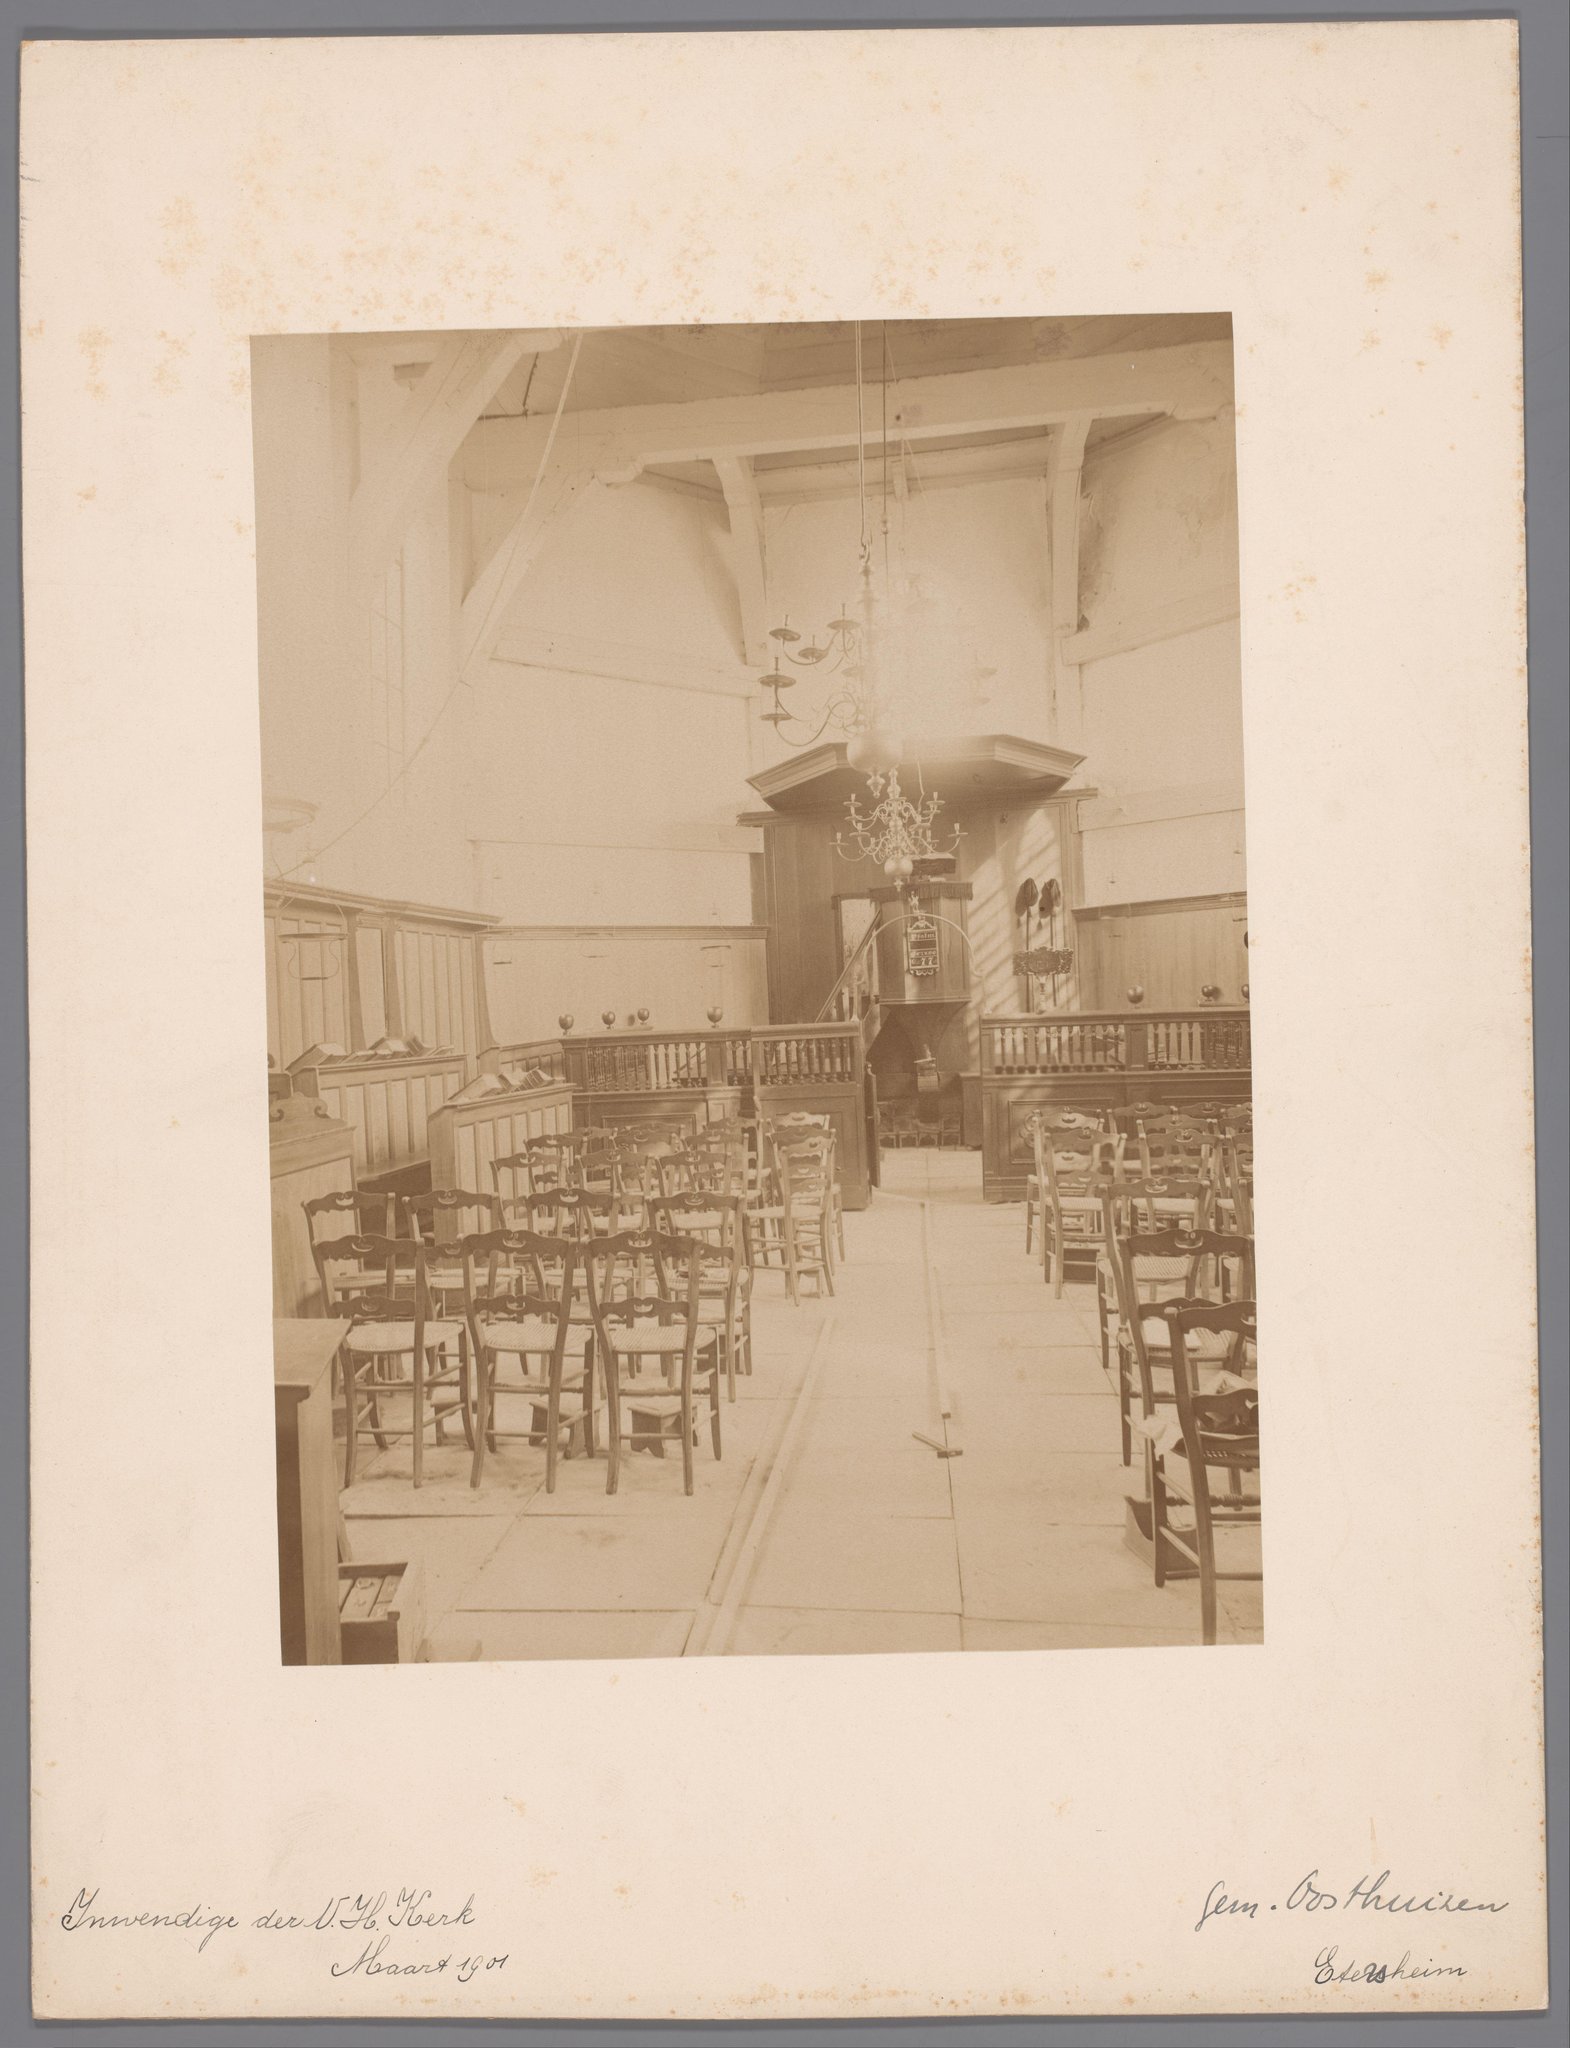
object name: photograph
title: Interieur van de Oude Kerk te Etersheim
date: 1901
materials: cardboard, photographic support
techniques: albumen print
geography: etersheim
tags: interior of church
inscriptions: annotation: ‘Het inwendige der kerk/ der Ned Herv gemeente te Etersheim N.H./ Maart 1901’, annotation: ‘Inwendige der N.H. Kerk/ Maart 1901/ gem. Oosthuizen/ Etersheim’